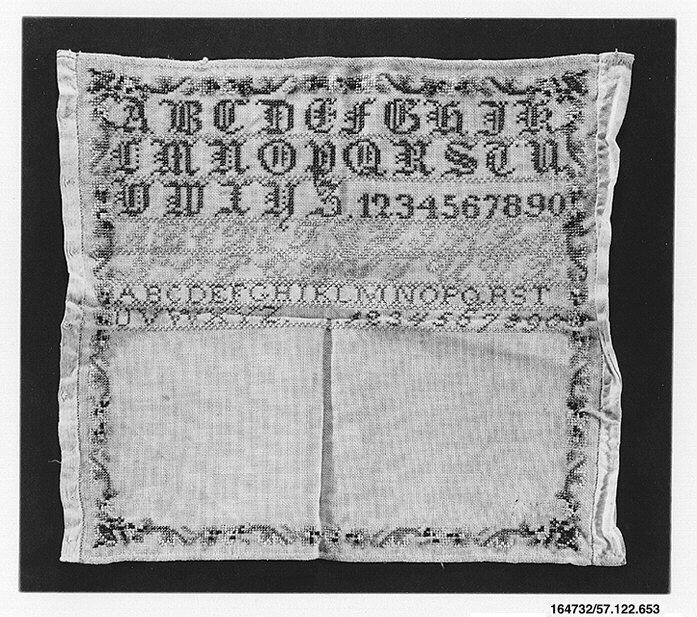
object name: sampler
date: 1801-1900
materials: canvas, cotton, silk